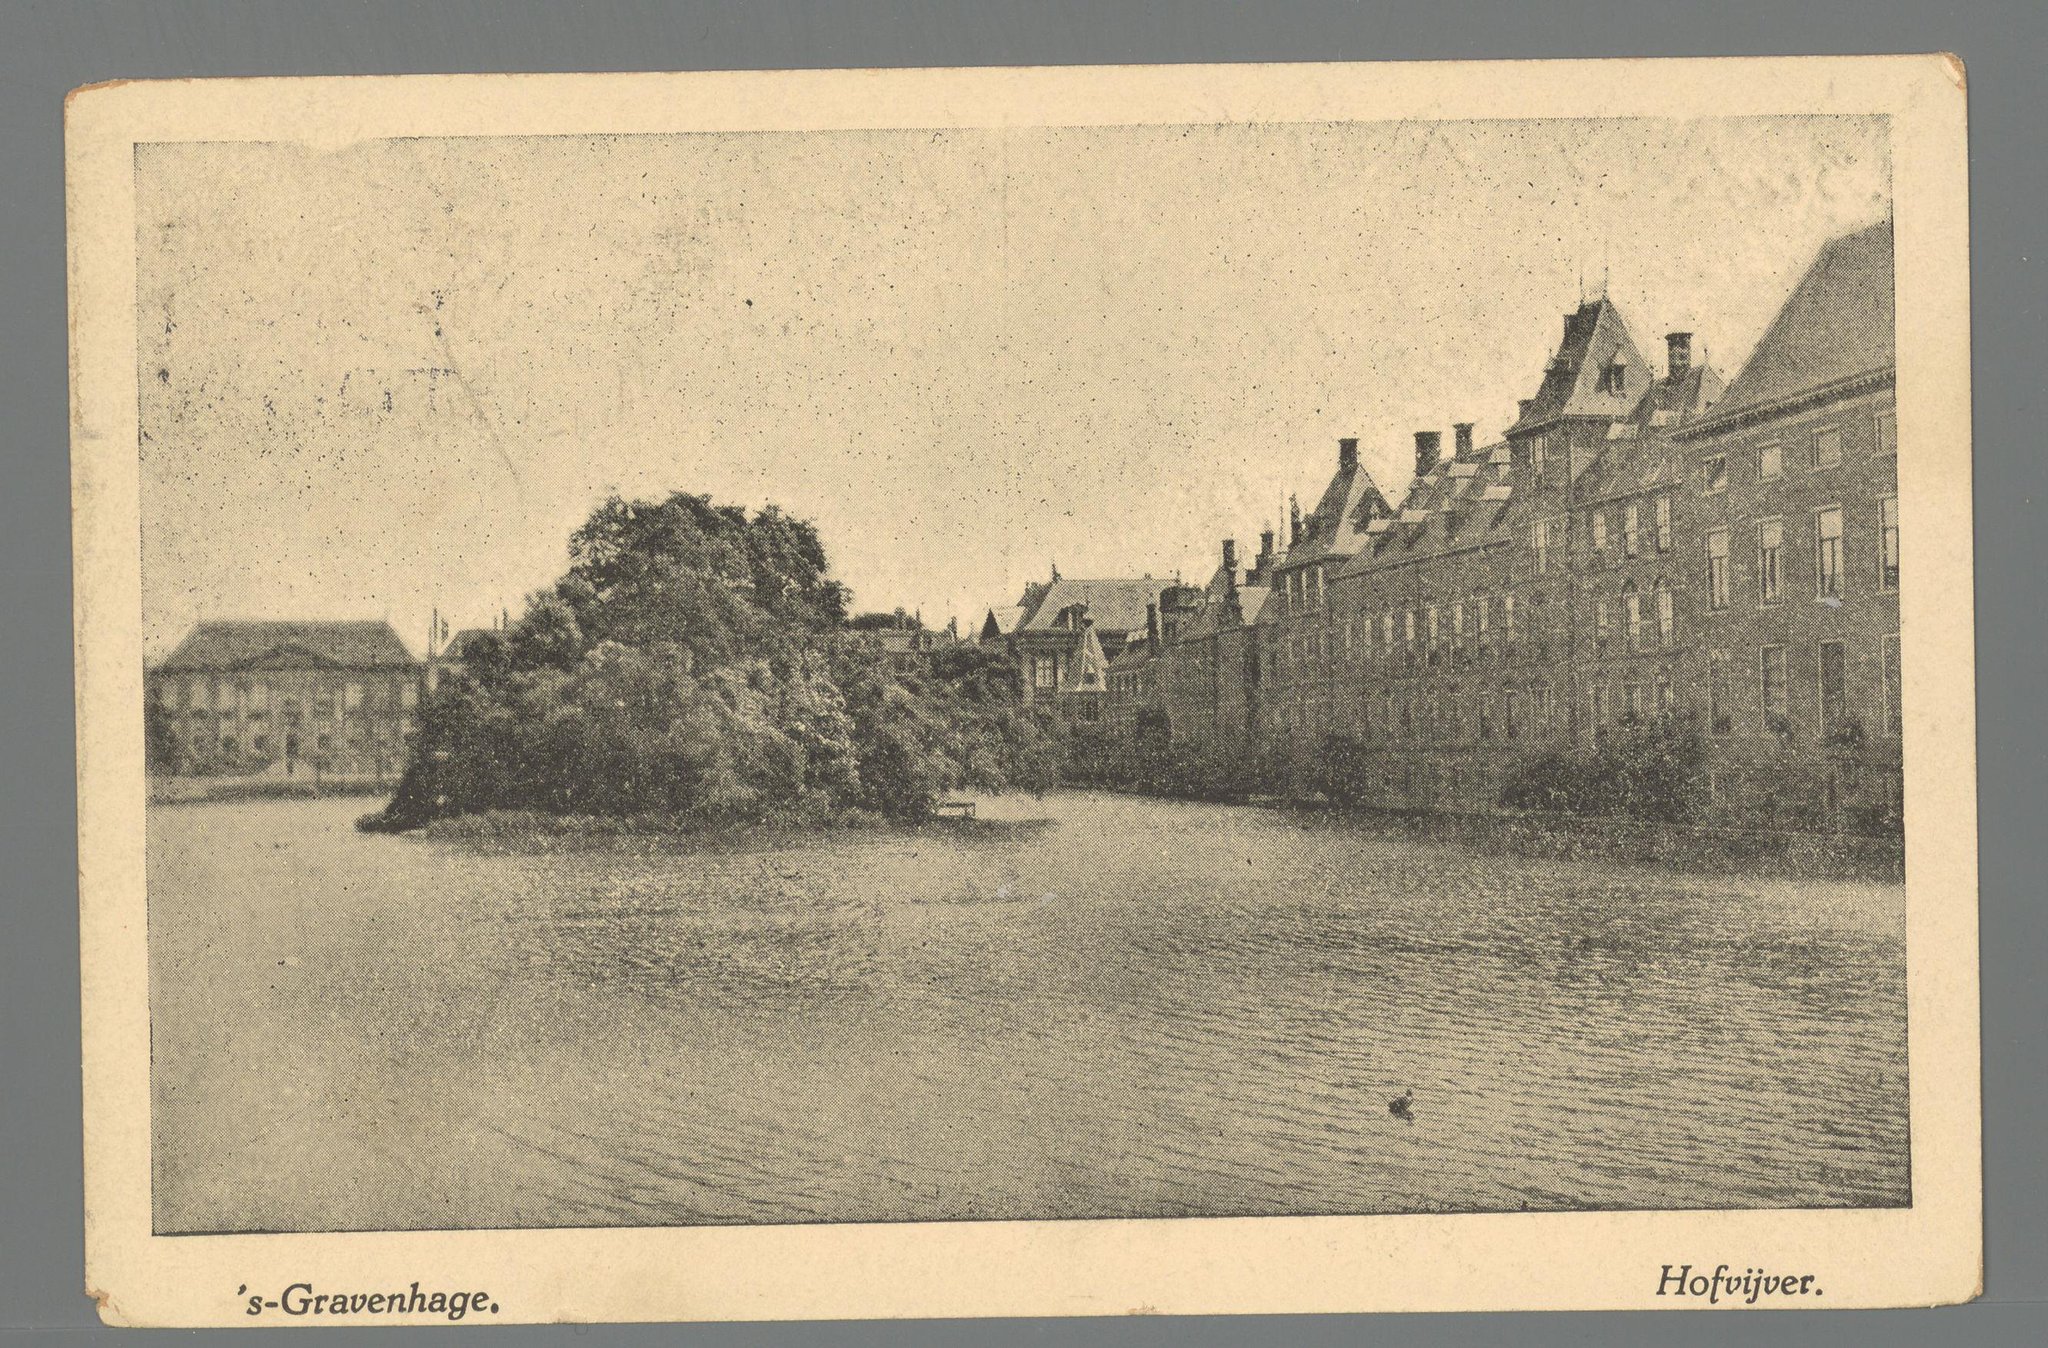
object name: photomechanical print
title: 's-Gravenhage. Hofvijver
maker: Anonymous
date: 1913-1926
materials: cardboard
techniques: writing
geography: the hague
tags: city-view, and landscape with man-made constructions, pond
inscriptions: postage stamp